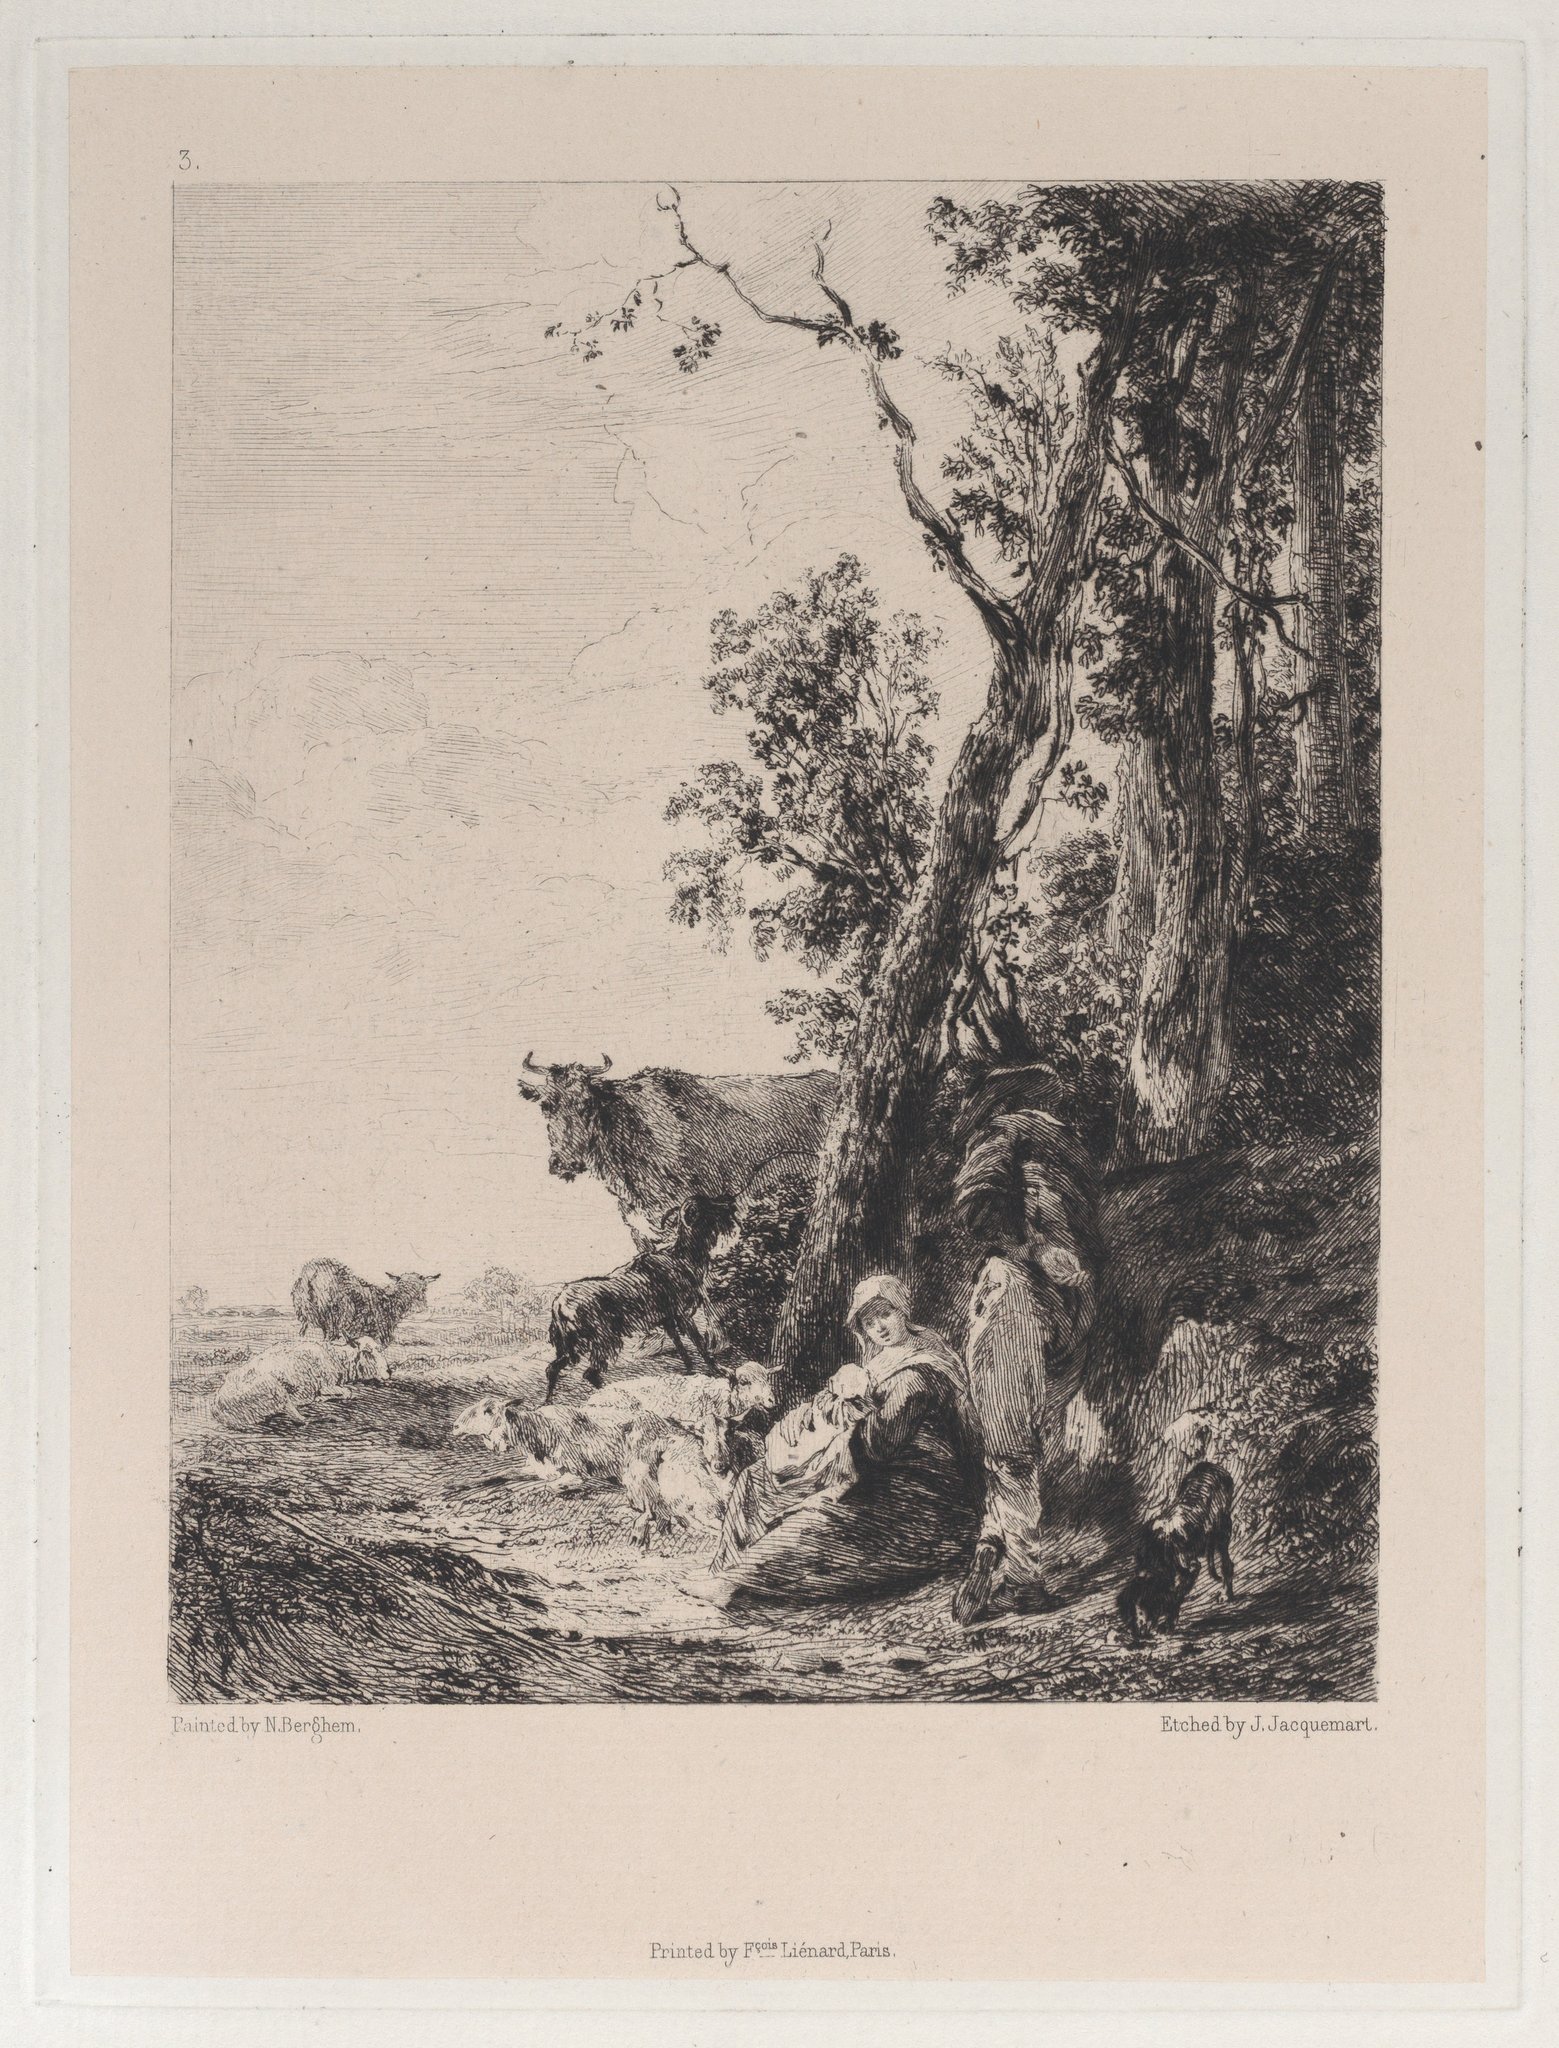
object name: print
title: Rest, a Landscape with Figures and Cattle, after Nicolaes Berchem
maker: jules-ferdinand jacquemart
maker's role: artist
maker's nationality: french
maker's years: 1837-1880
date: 1871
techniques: printmaking, etching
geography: paris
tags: women,cows,sheep